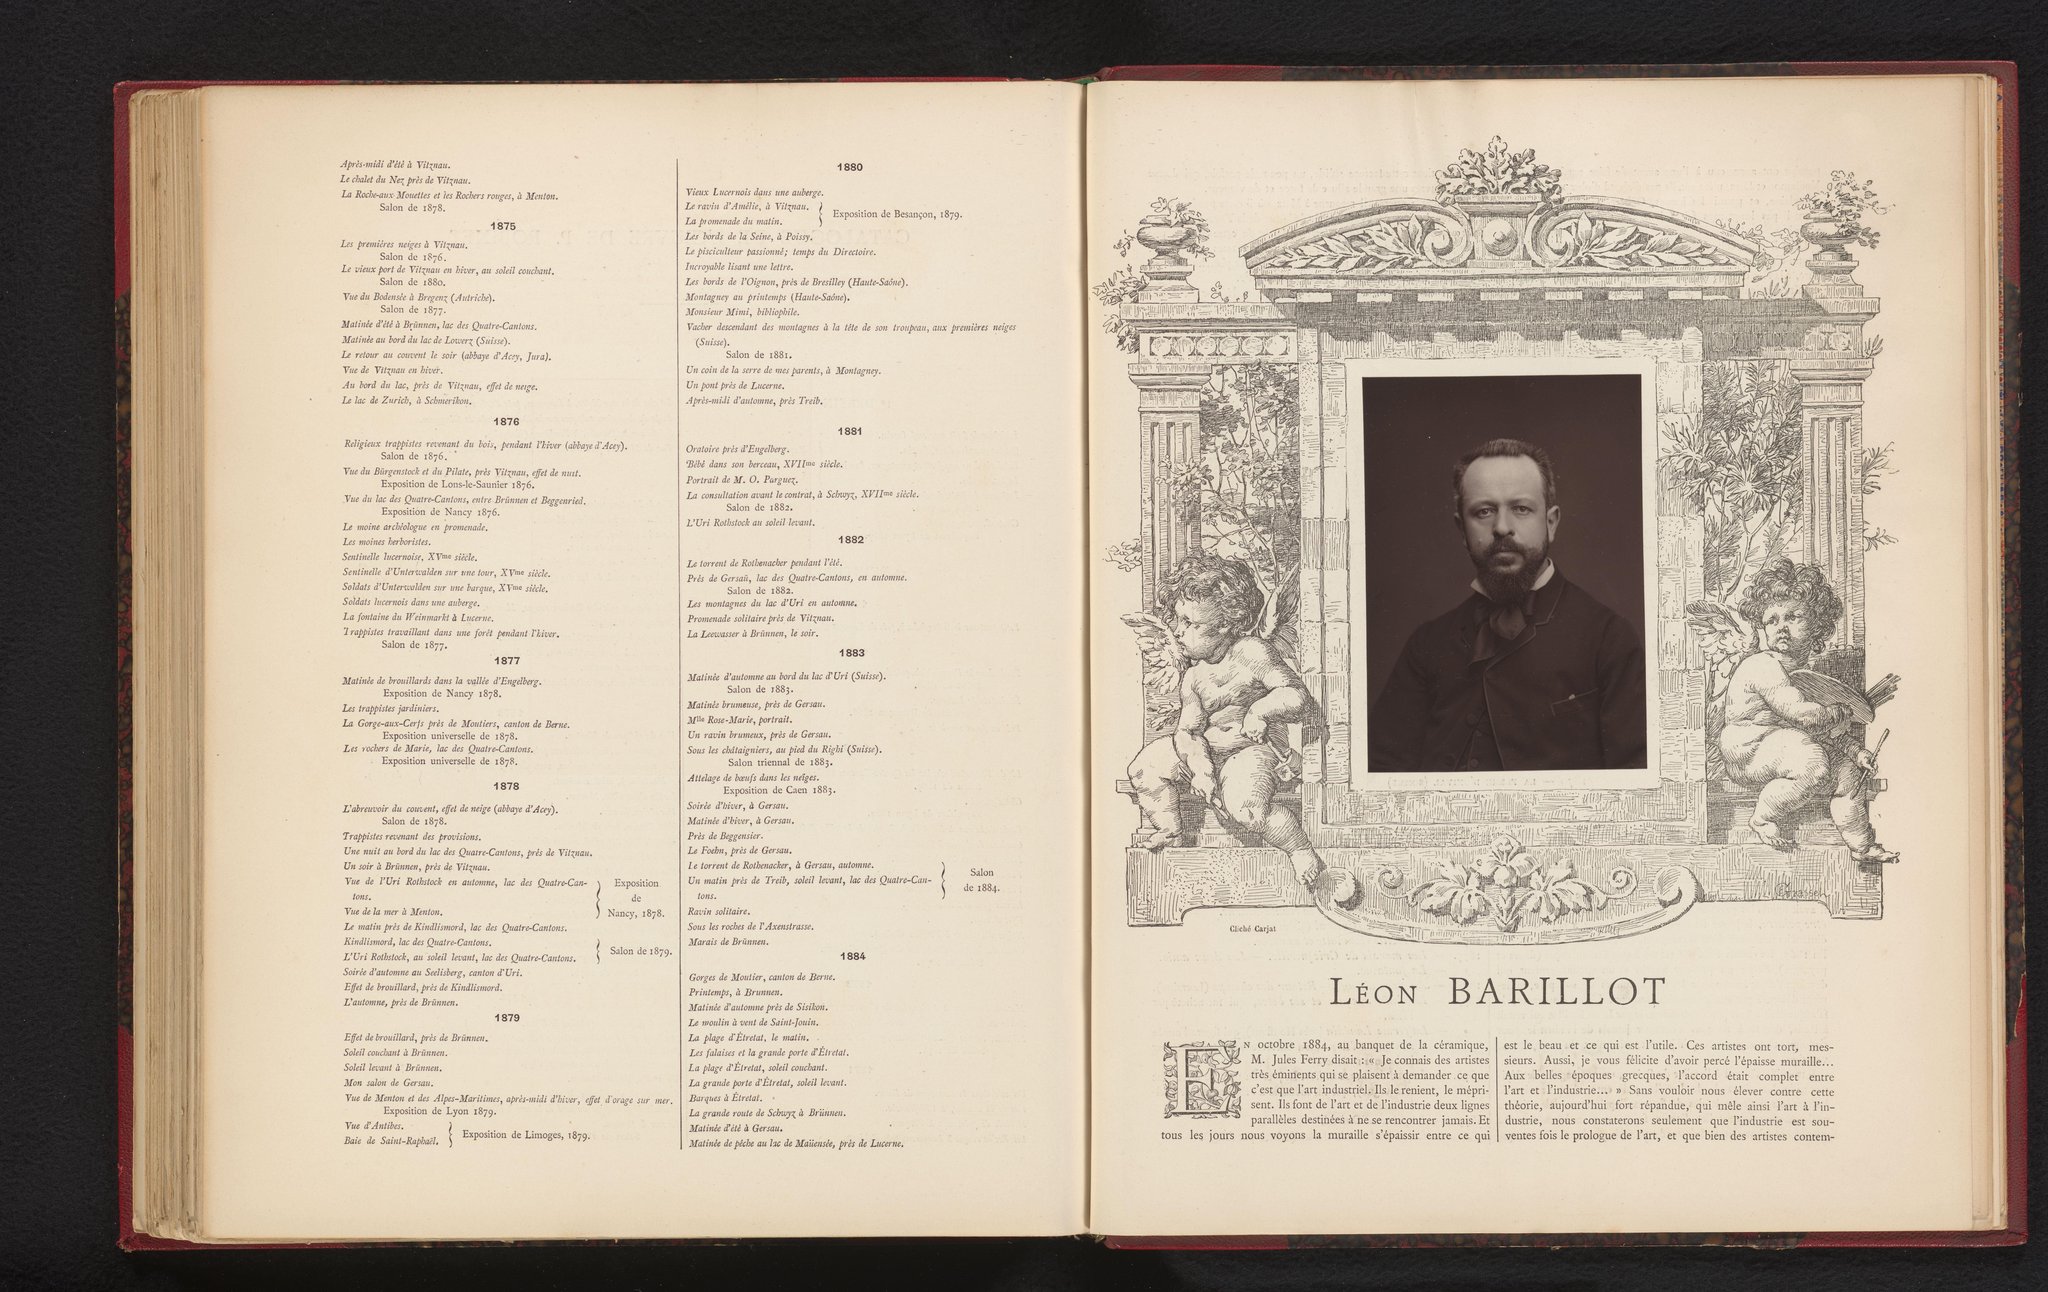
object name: photomechanical print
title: Portret van Léon Barillot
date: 1879-1884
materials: paper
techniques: woodburytype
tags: print maker, léon barillot, historical persons